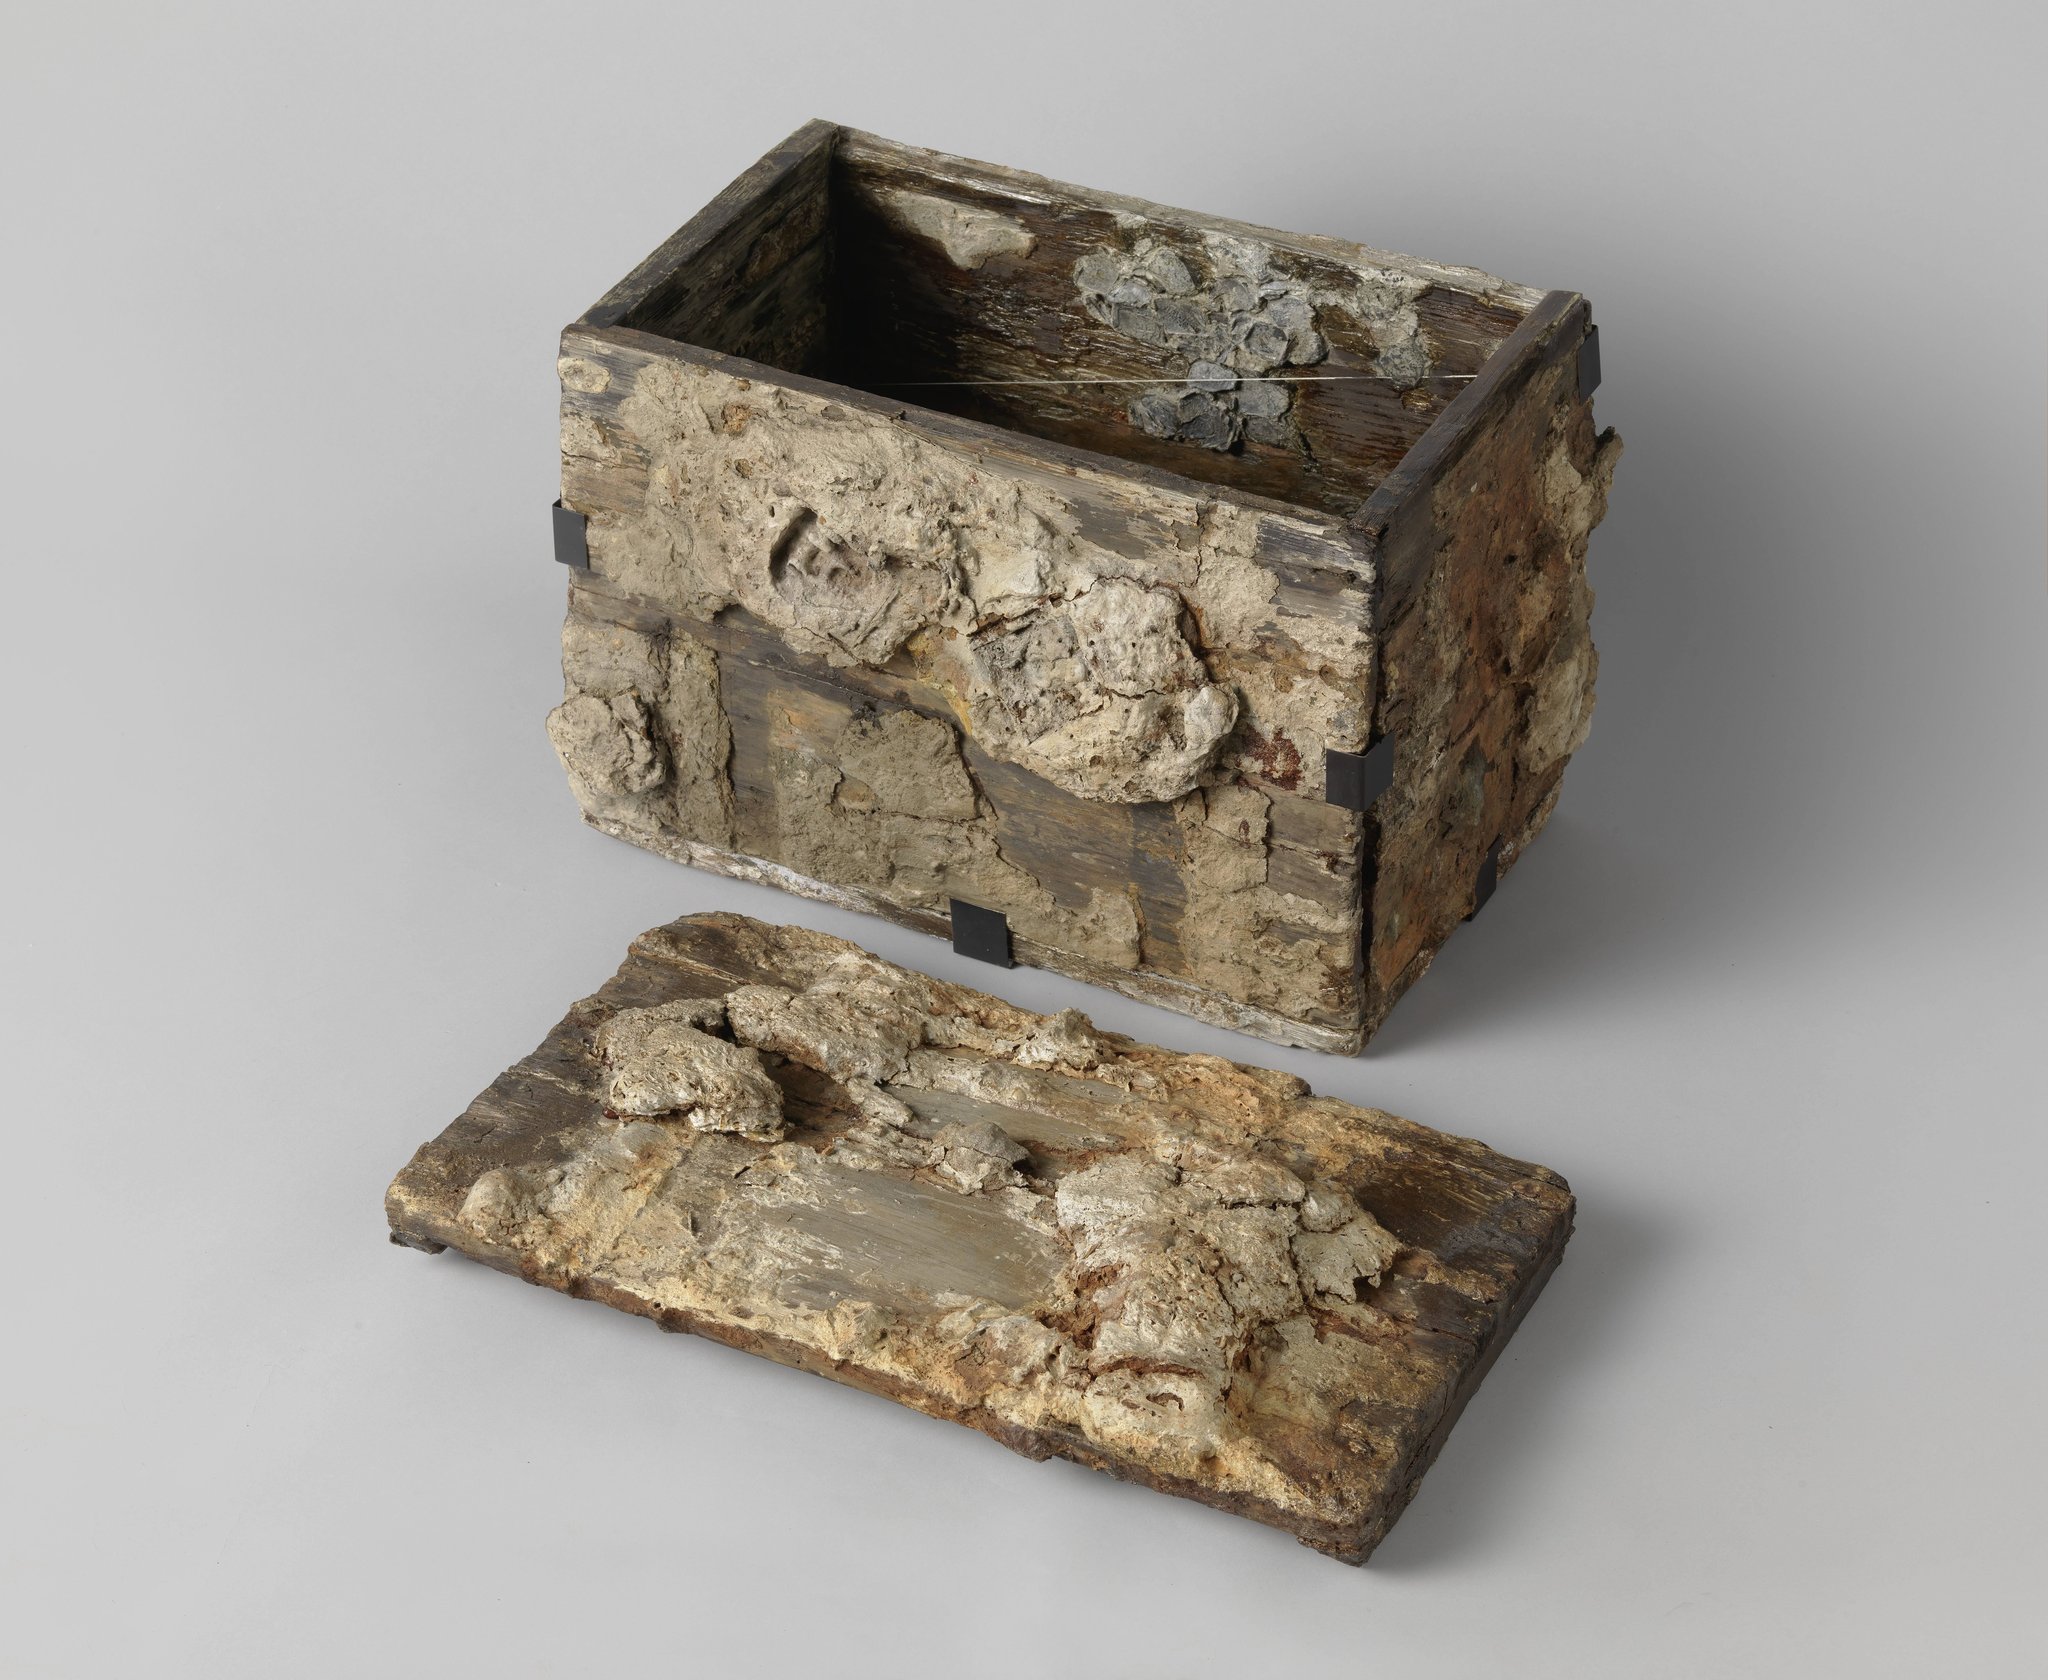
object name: strongbox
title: Kist uit het wrak van de Oost-Indiëvaarder 't Vliegend Hart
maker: Anonymous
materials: wood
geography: middelburg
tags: 't vliegend hart (schip), verenigde oostindische compagnie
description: Houten complete geldkist met resten van ijzerbeslag en sloten, zeildoek en touw. Van deze kisten waren er drie aan boord van de Vliegend Hart waarin de contanten werden vervoerd die de Compagnie gebruikte voor de handel in Azië. De kist bevatte zakken zilver en goud, gestouwd met turf. chest, complete.